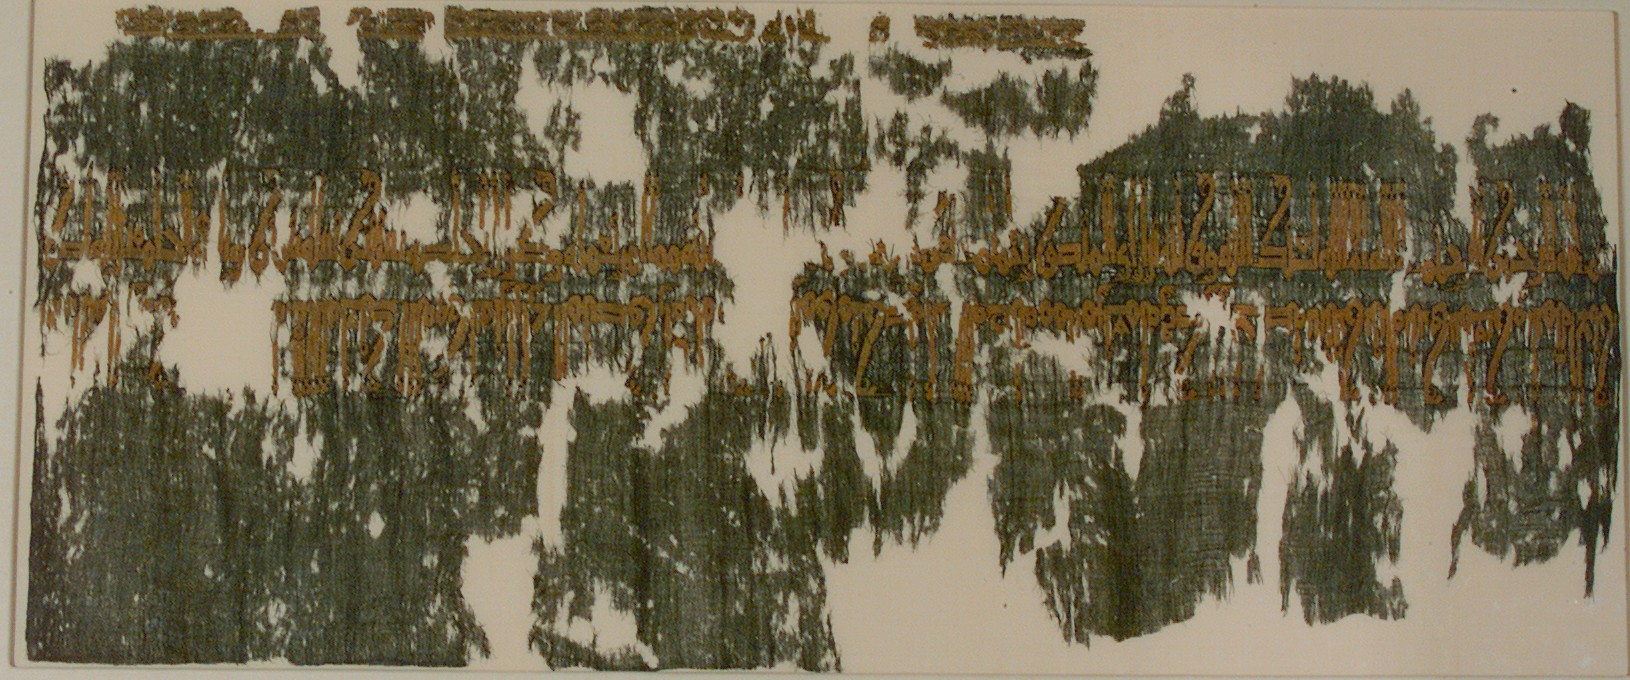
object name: tiraz fragment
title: Tiraz Veil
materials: silk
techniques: weave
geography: egypt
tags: arabic